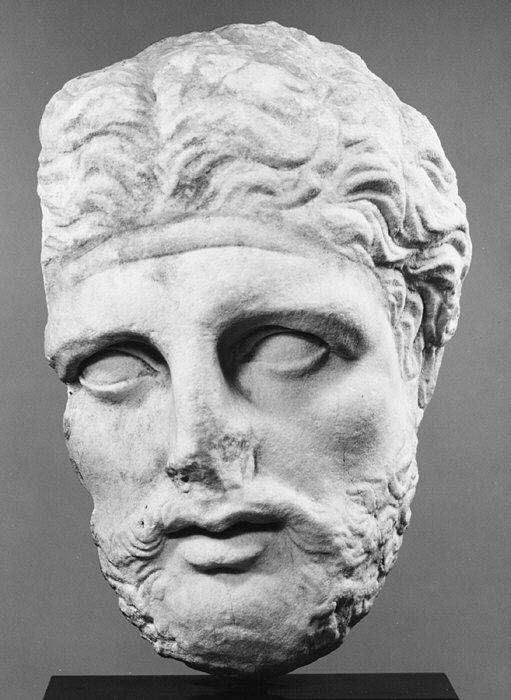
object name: grave relief fragment, head of a man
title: Marble head of a bearded man from a stele (grave marker)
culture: greek, attic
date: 350-325 BCE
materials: marble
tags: heads,men